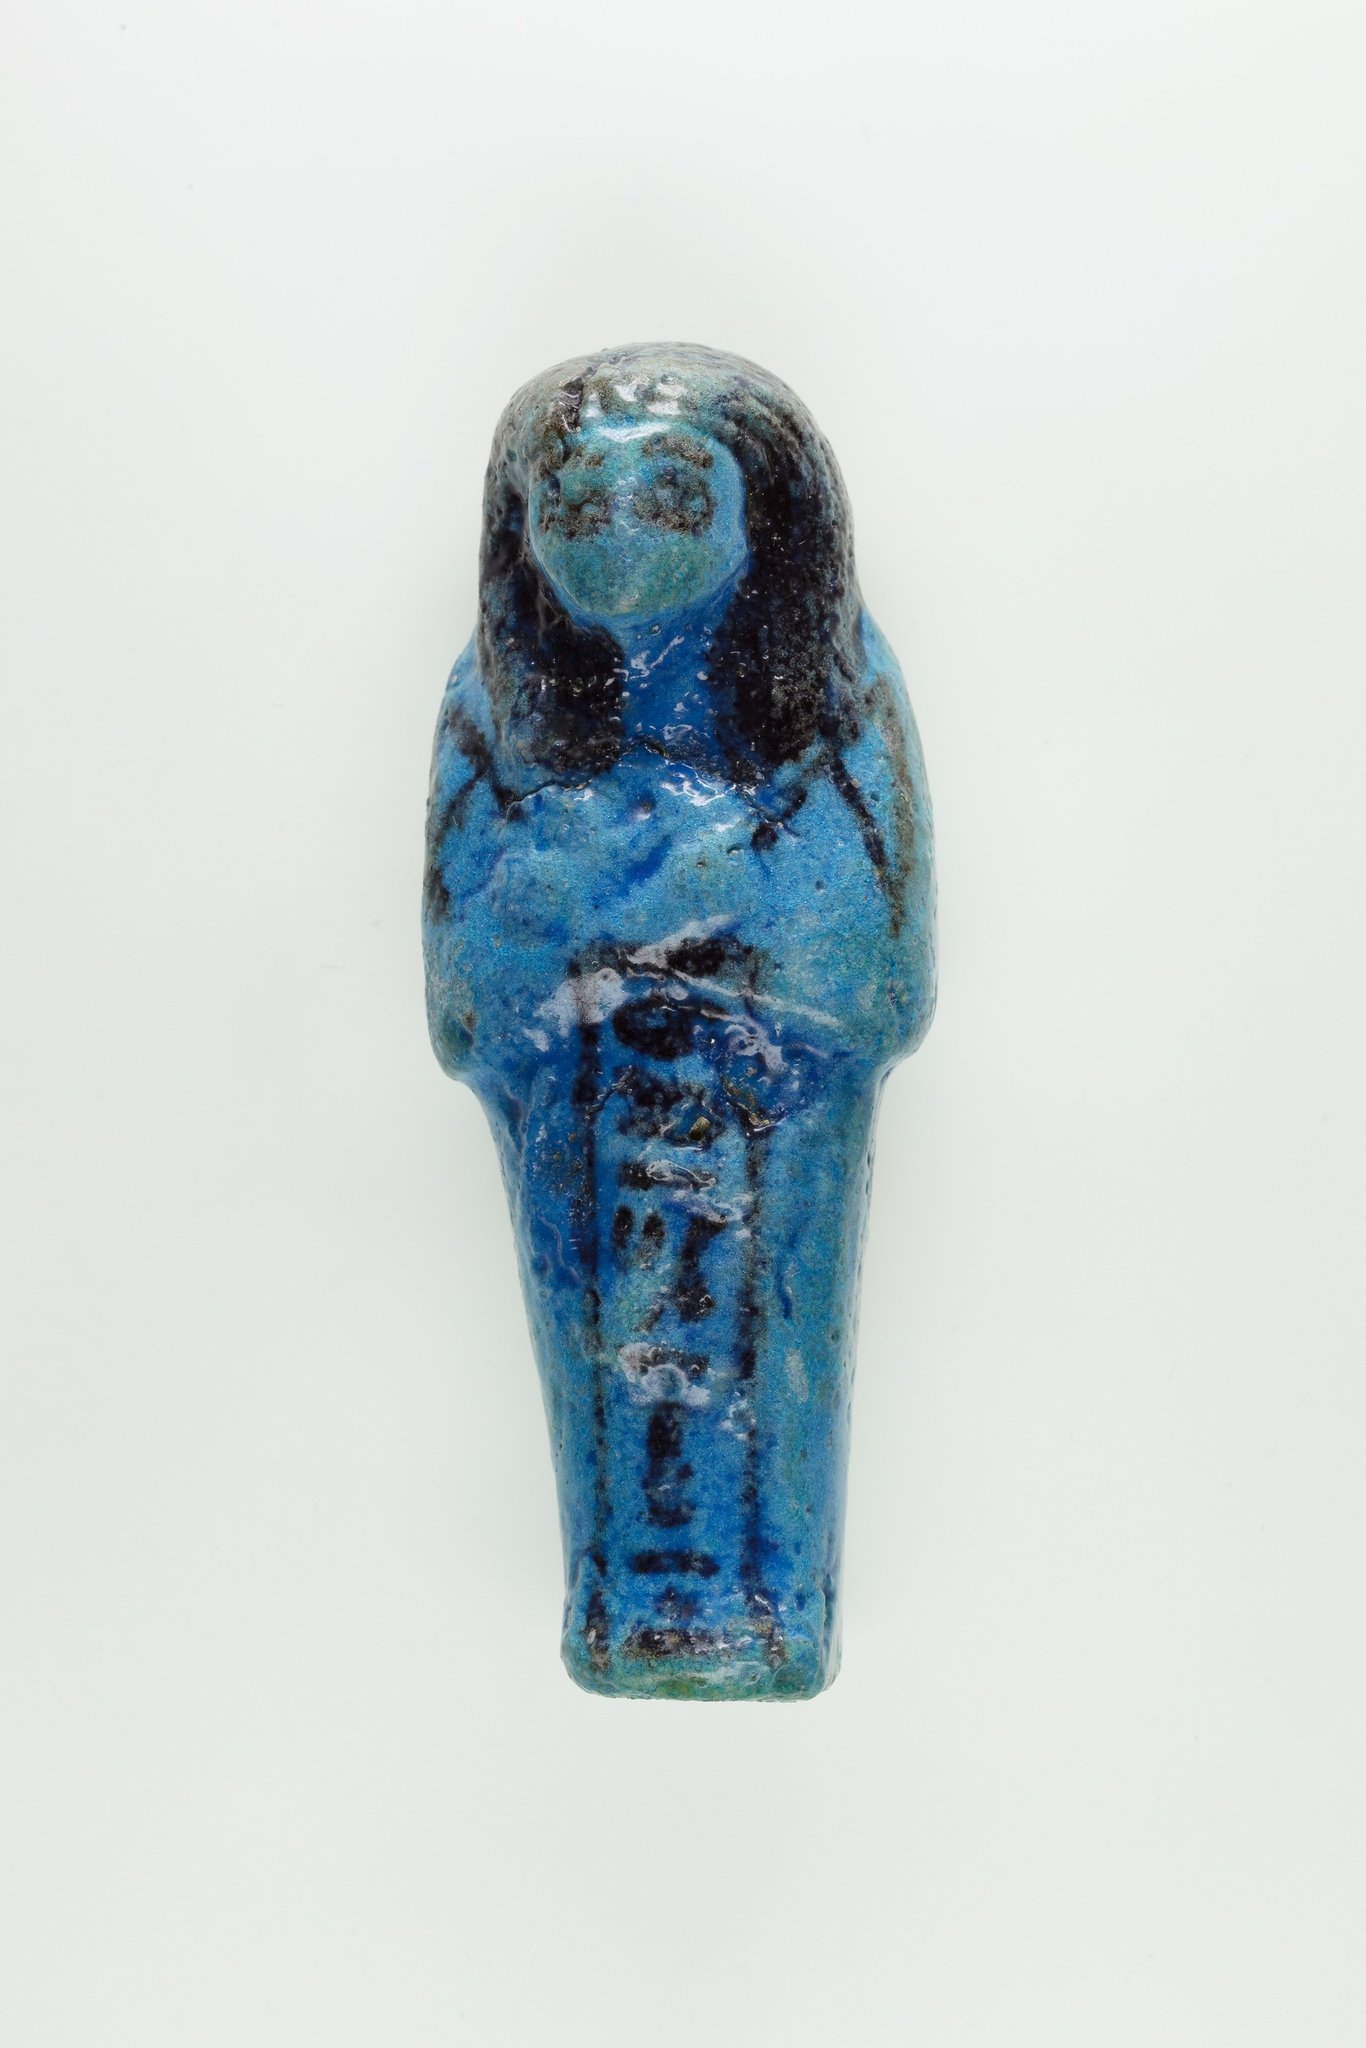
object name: shabti, worker, nauny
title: Worker Shabti of Nauny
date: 1050 BCE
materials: faience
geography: egypt